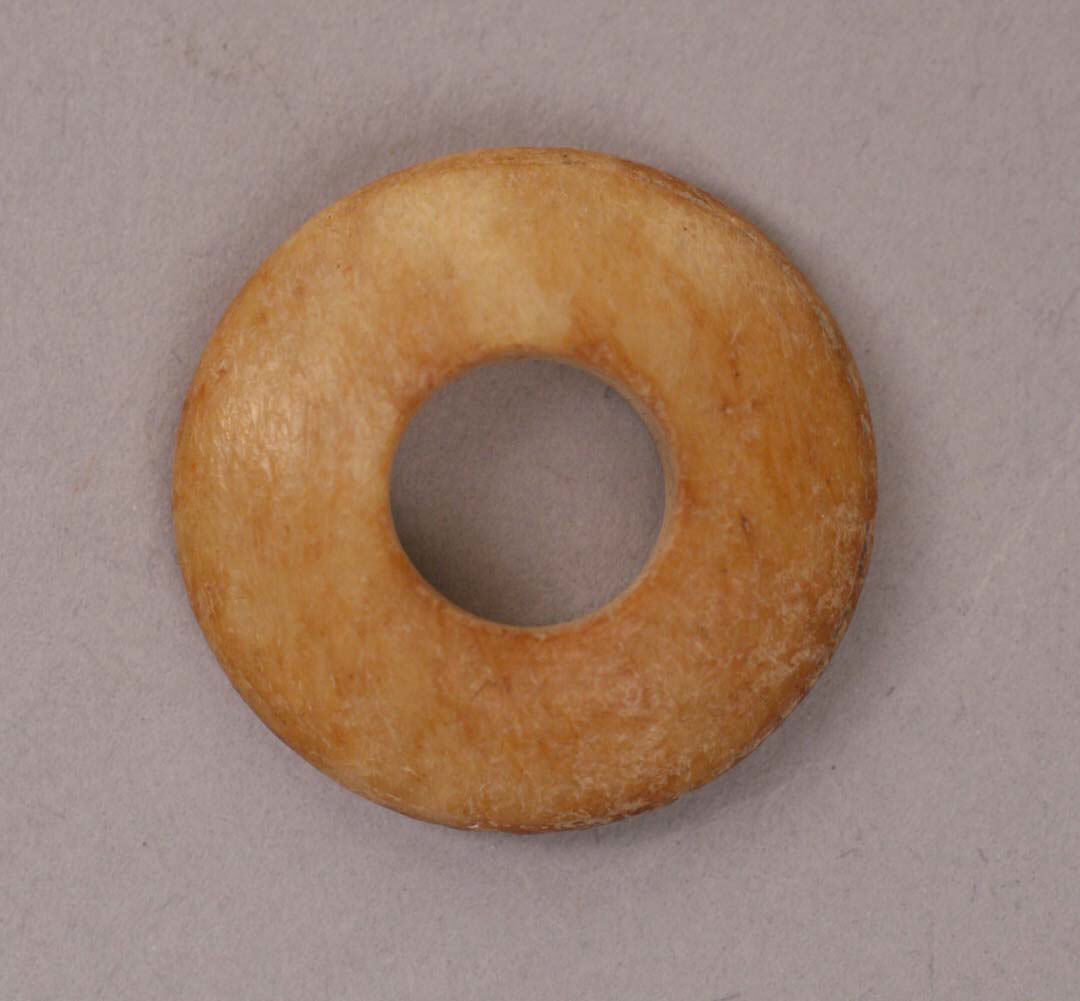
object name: button or bead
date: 801-1000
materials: bone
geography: iran